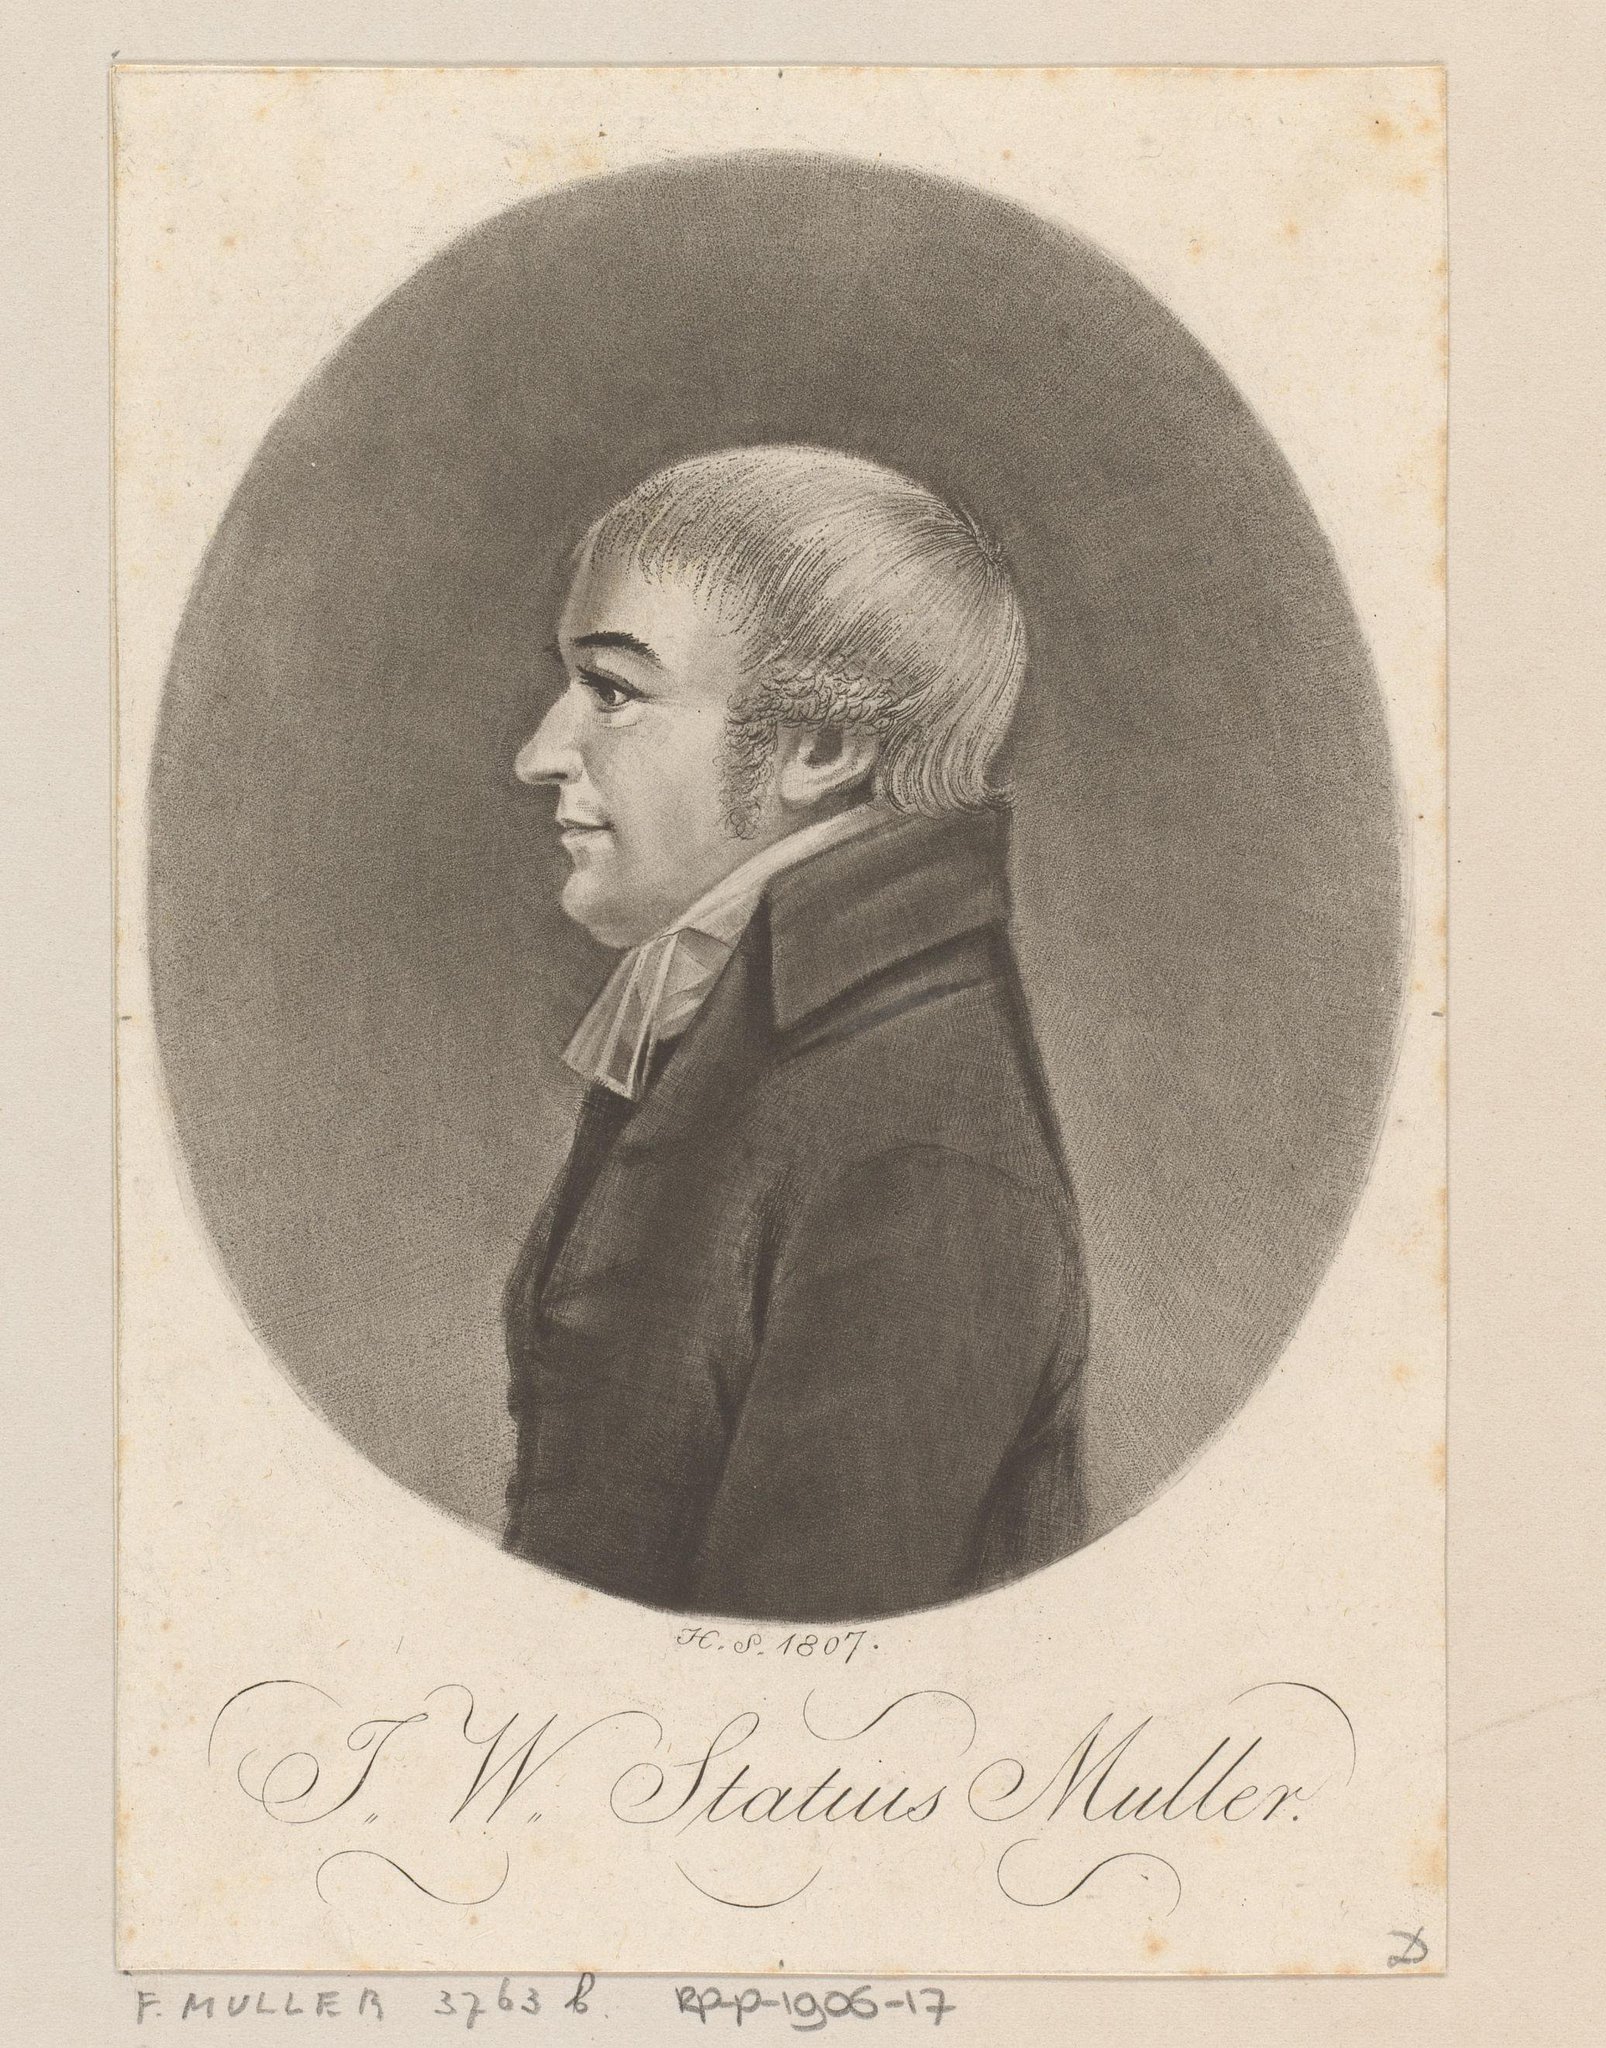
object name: print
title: J.W. Statius Muller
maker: hendrik schwegman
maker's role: draughtsman, print maker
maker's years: 1761-1816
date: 1807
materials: paper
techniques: engraving, etching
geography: haarlem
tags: maastricht, organizations, assemblies, etc. in protestant churches, historical persons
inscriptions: collector's mark: Lugt 2228